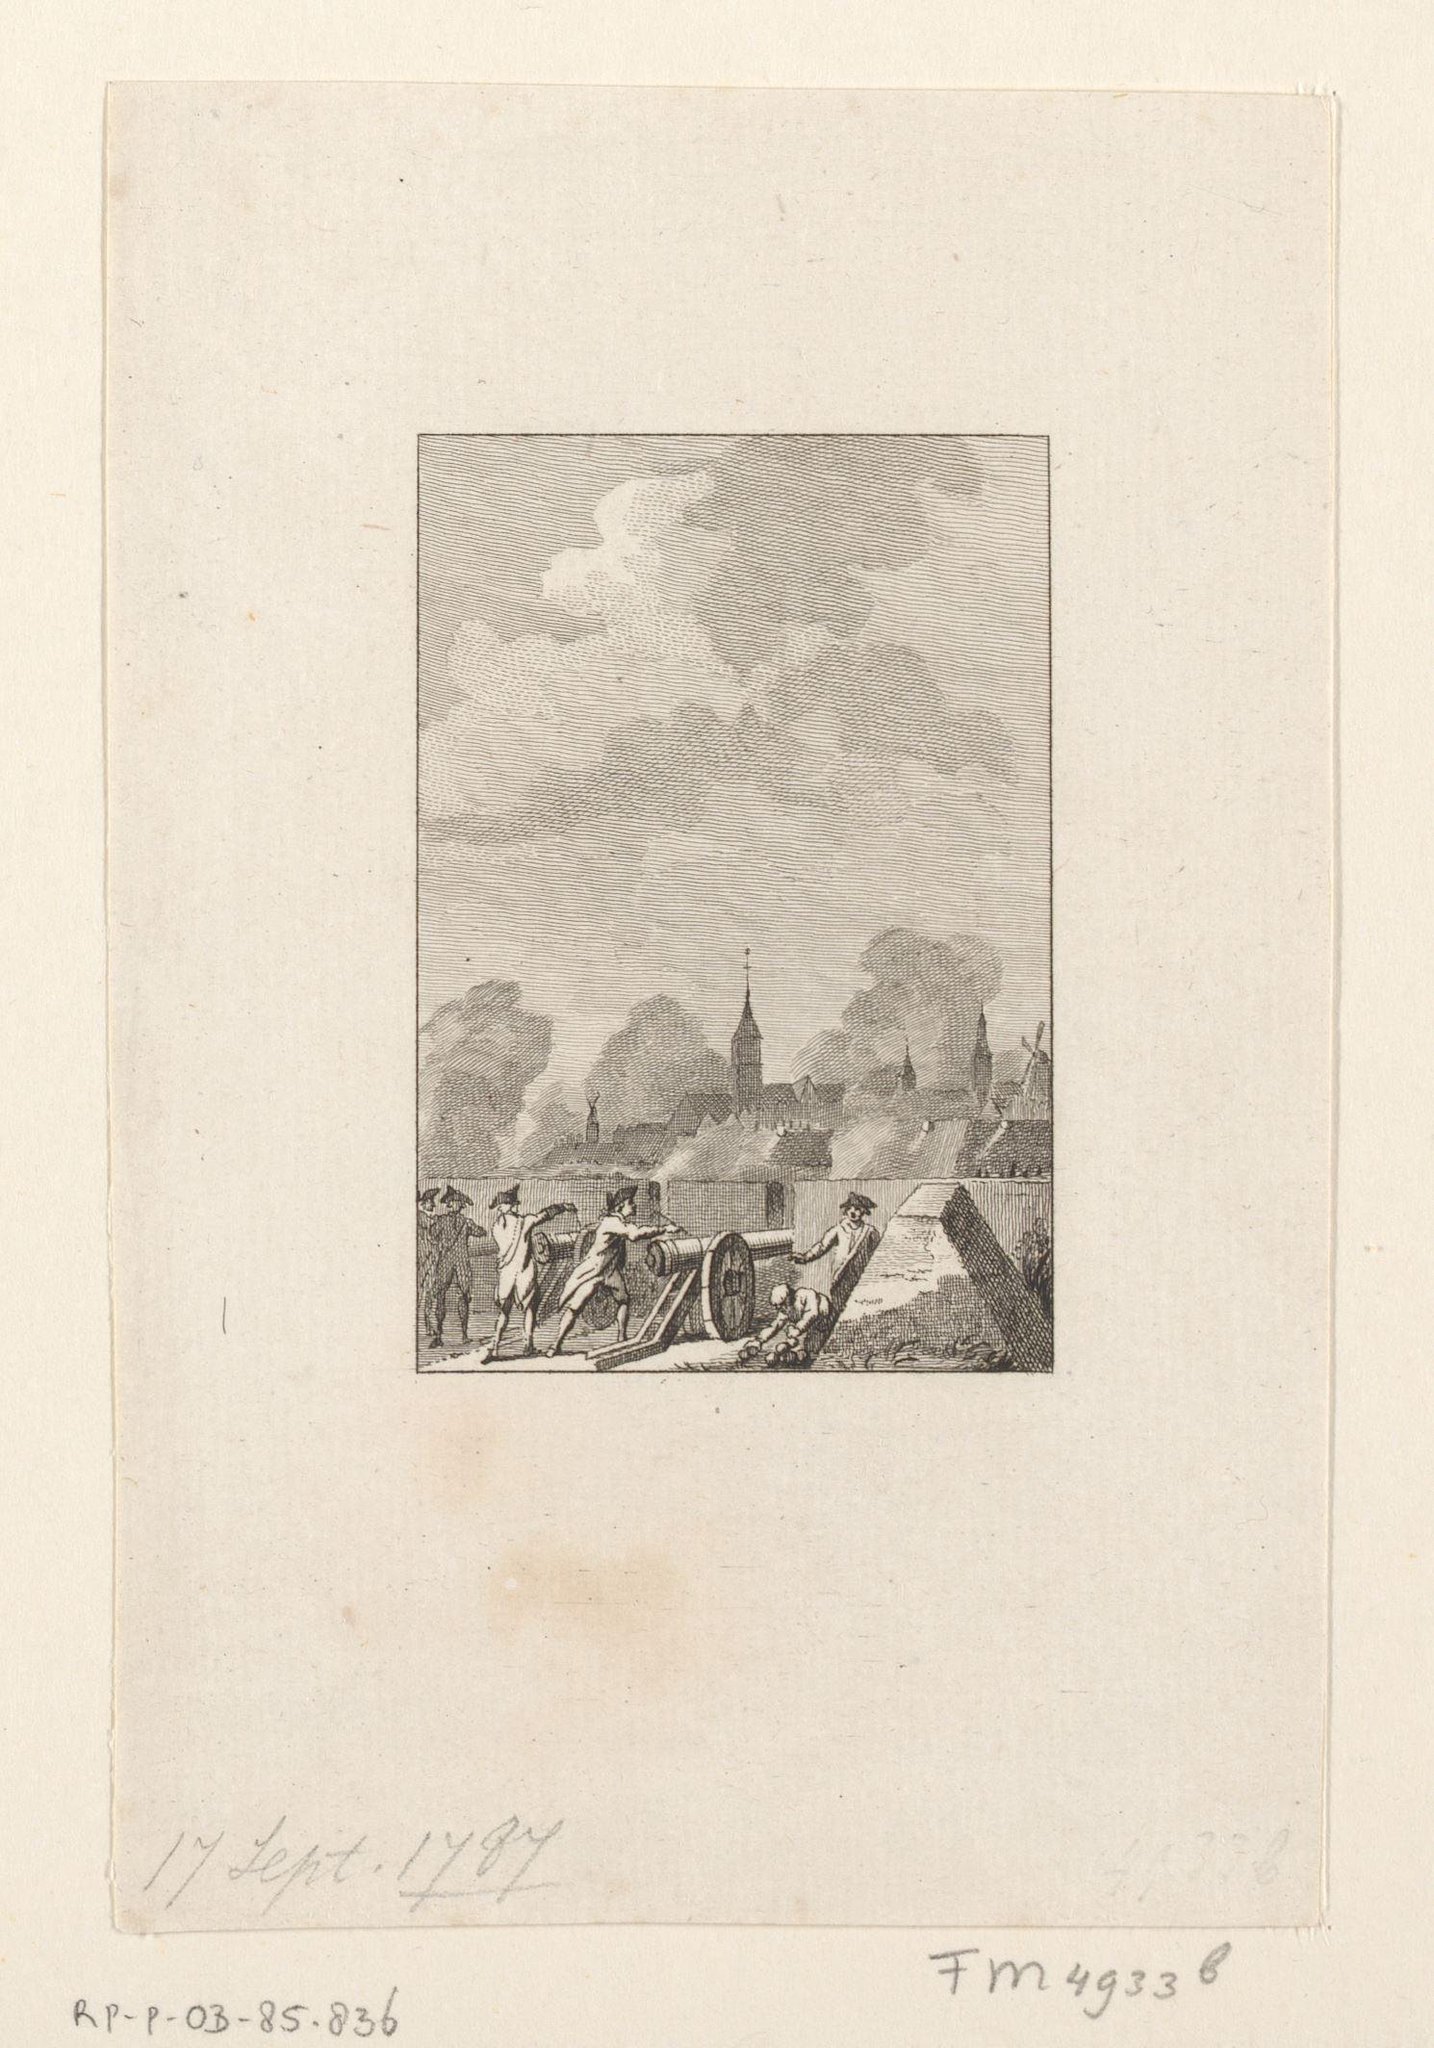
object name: print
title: Pruisen beschieten Gorinchem, 1787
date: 1787-1795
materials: paper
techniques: engraving, etching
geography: northern netherlands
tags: siege, position war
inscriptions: collector's mark: Lugt 2228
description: Gebruikt als illustratie in: J. Fokke, Geschiedenissen der Vereenigde Nederlanden voor de vaderlandsche jeugd, Johannes Allart, Amsterdam 1783-1795, 25 delen, dl. 19, pl. 9.